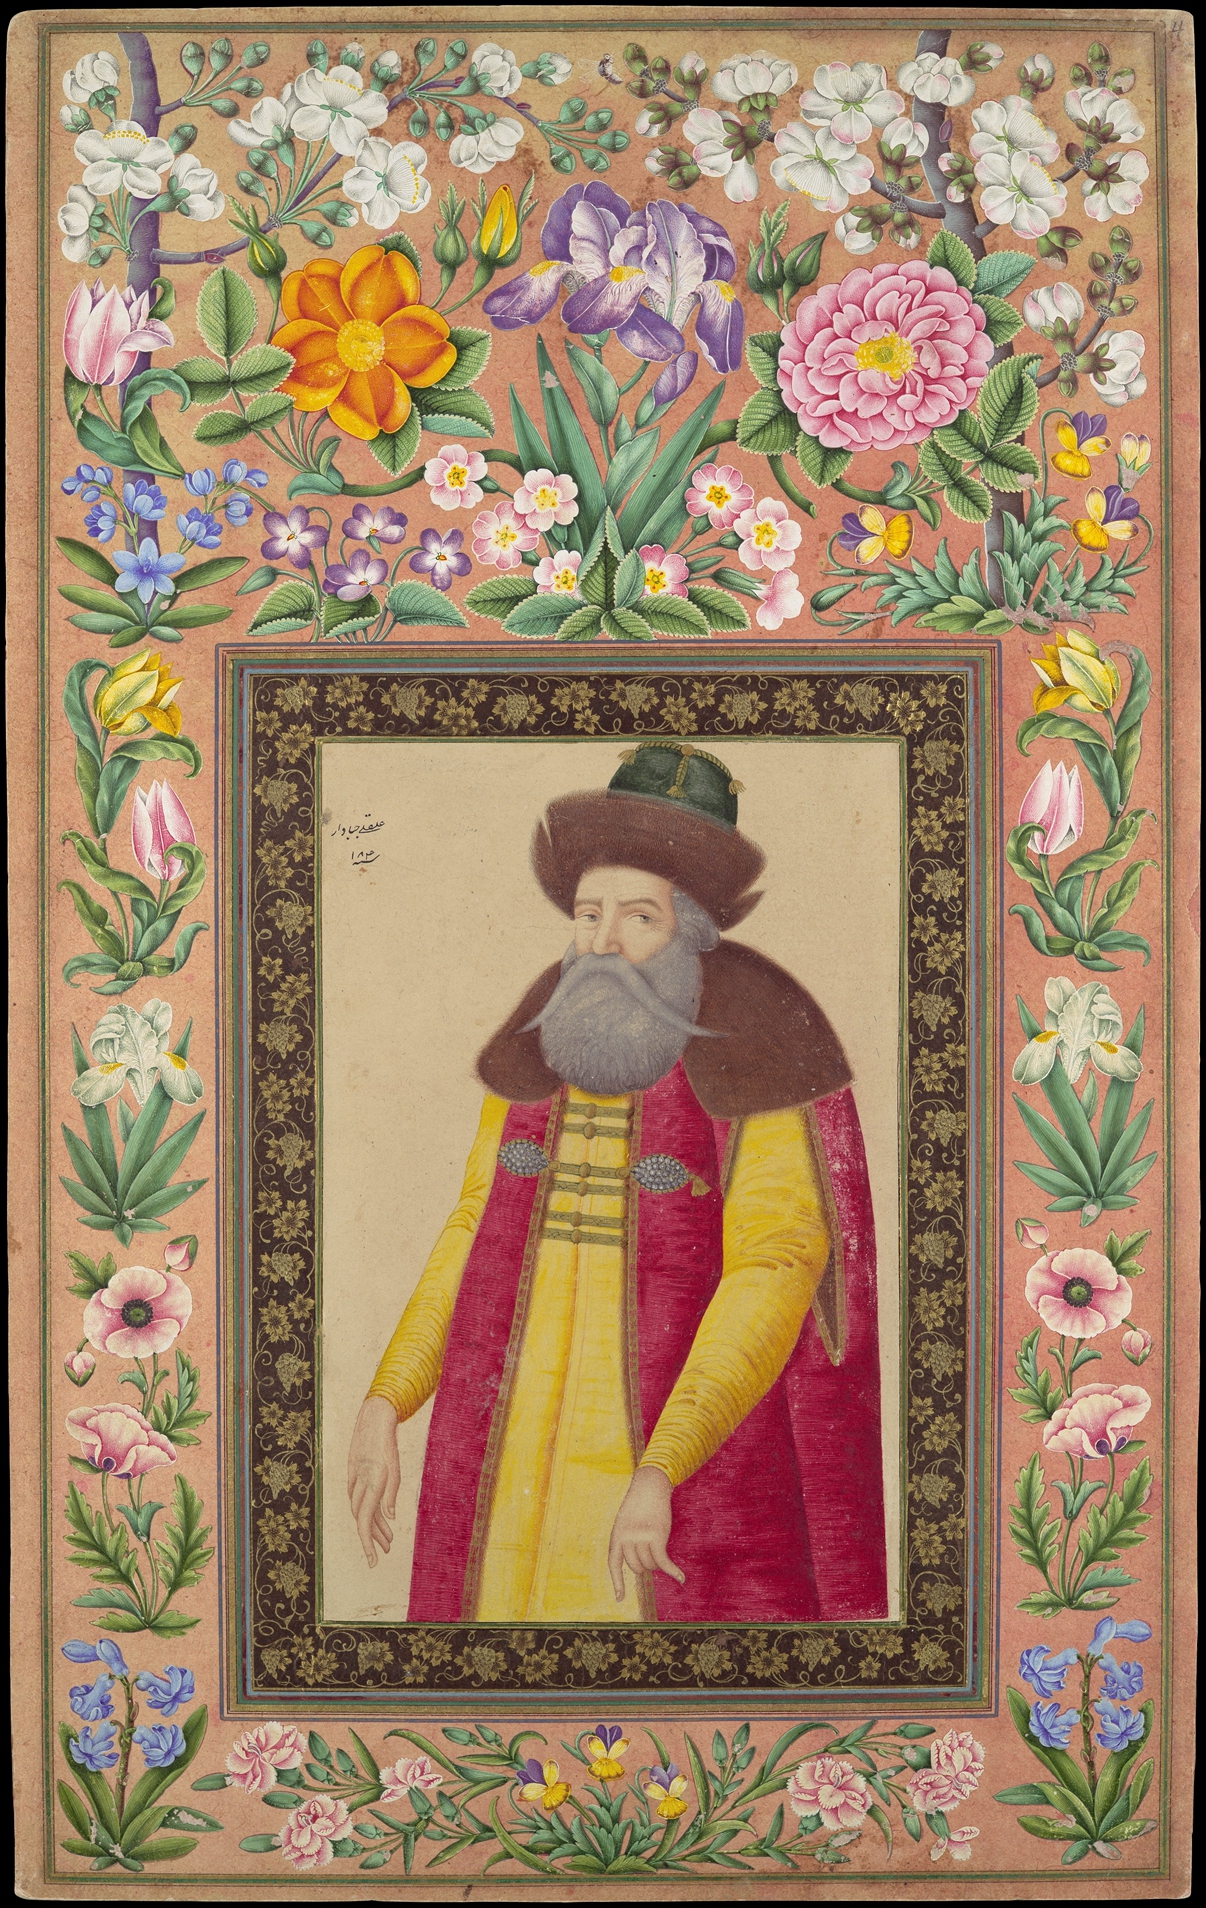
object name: illustrated album leaf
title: "Portrait of the Russian Ambassador, Prince Andrey Priklonskiy", Folio from the Davis Album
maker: 'ali quli jabbadar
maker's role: artist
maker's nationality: iranian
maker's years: 1620-1699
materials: gold, ink, paper, watercolor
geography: iran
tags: men,portraits,flowers,leaves